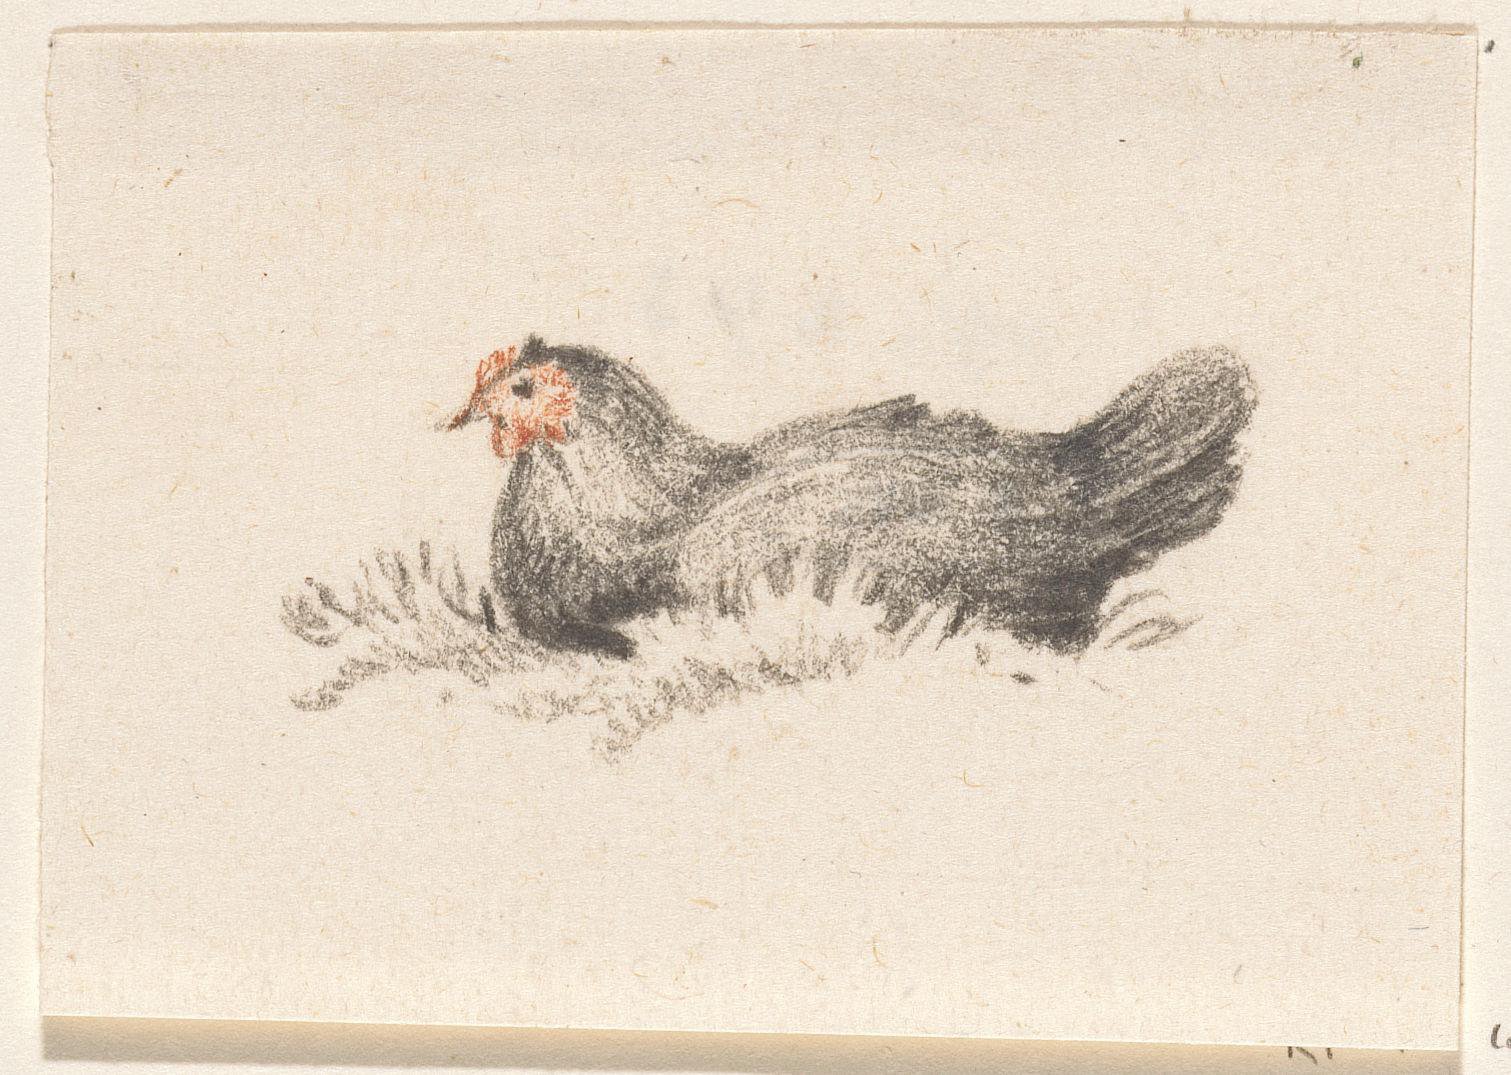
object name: drawing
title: Zittende kip, naar links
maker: jean bernard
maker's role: draughtsman, print maker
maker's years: 1765-1833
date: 1775-1833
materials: chalk, paper, pencil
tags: fowl (cock, hen, chicken, etc.)